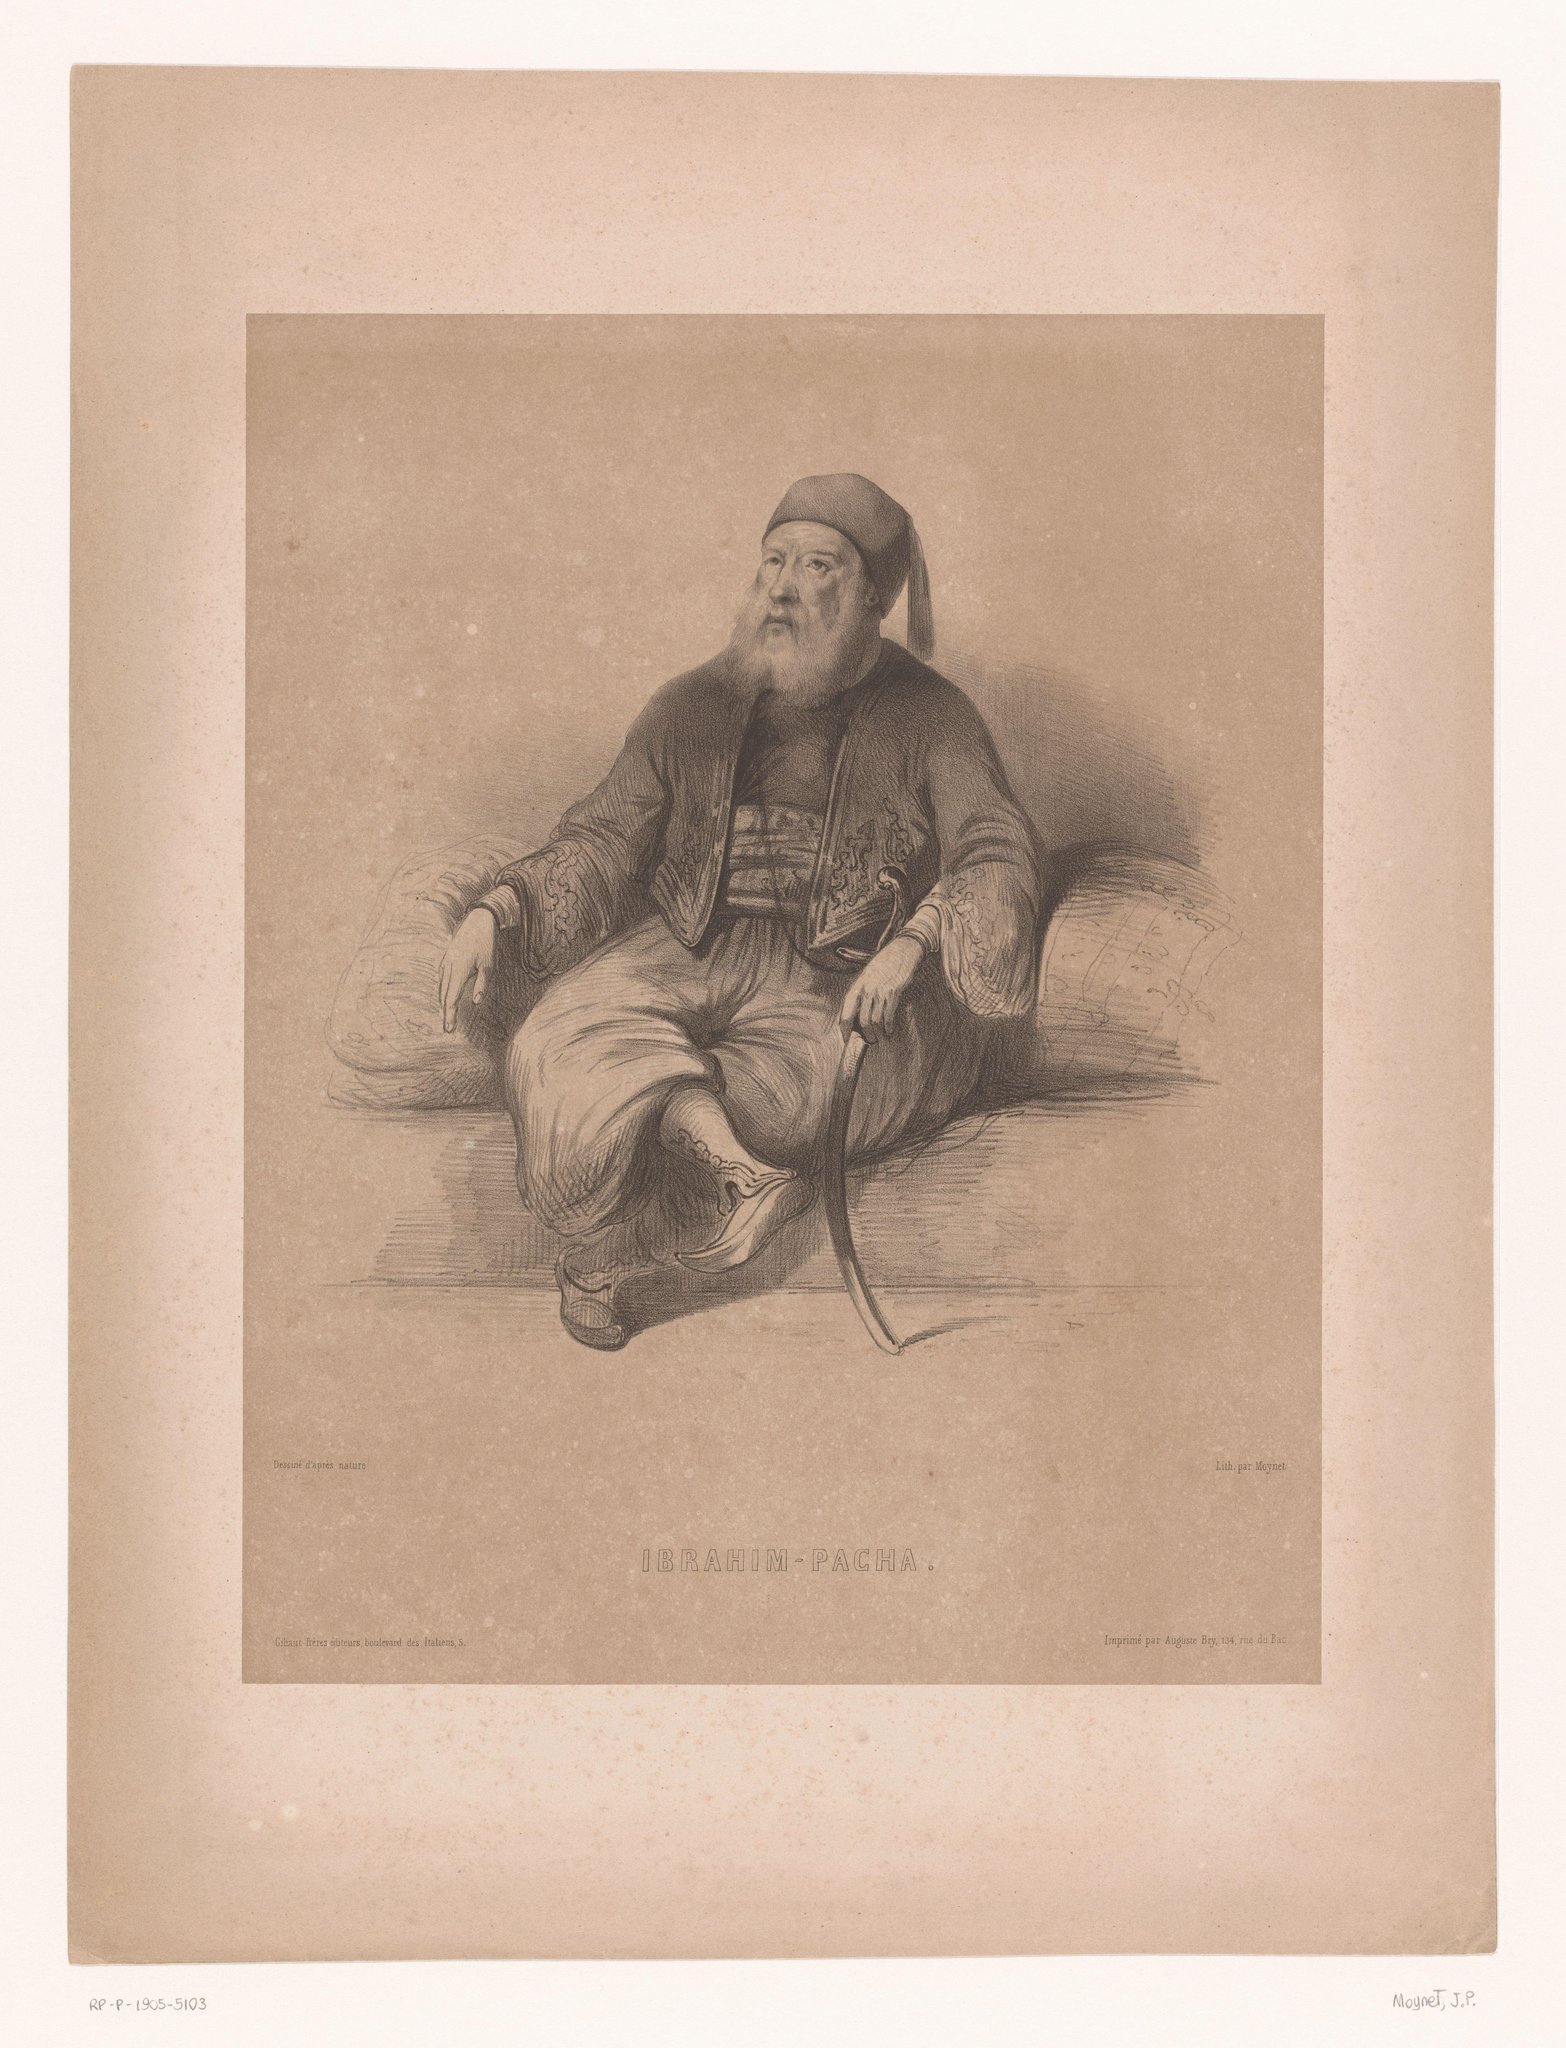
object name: print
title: Portret van Ibrahim Pasja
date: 1846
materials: paper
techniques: lithograph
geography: paris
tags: head-gear, hacking and thrusting weapons, historical persons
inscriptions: collector's mark: Lugt 2228